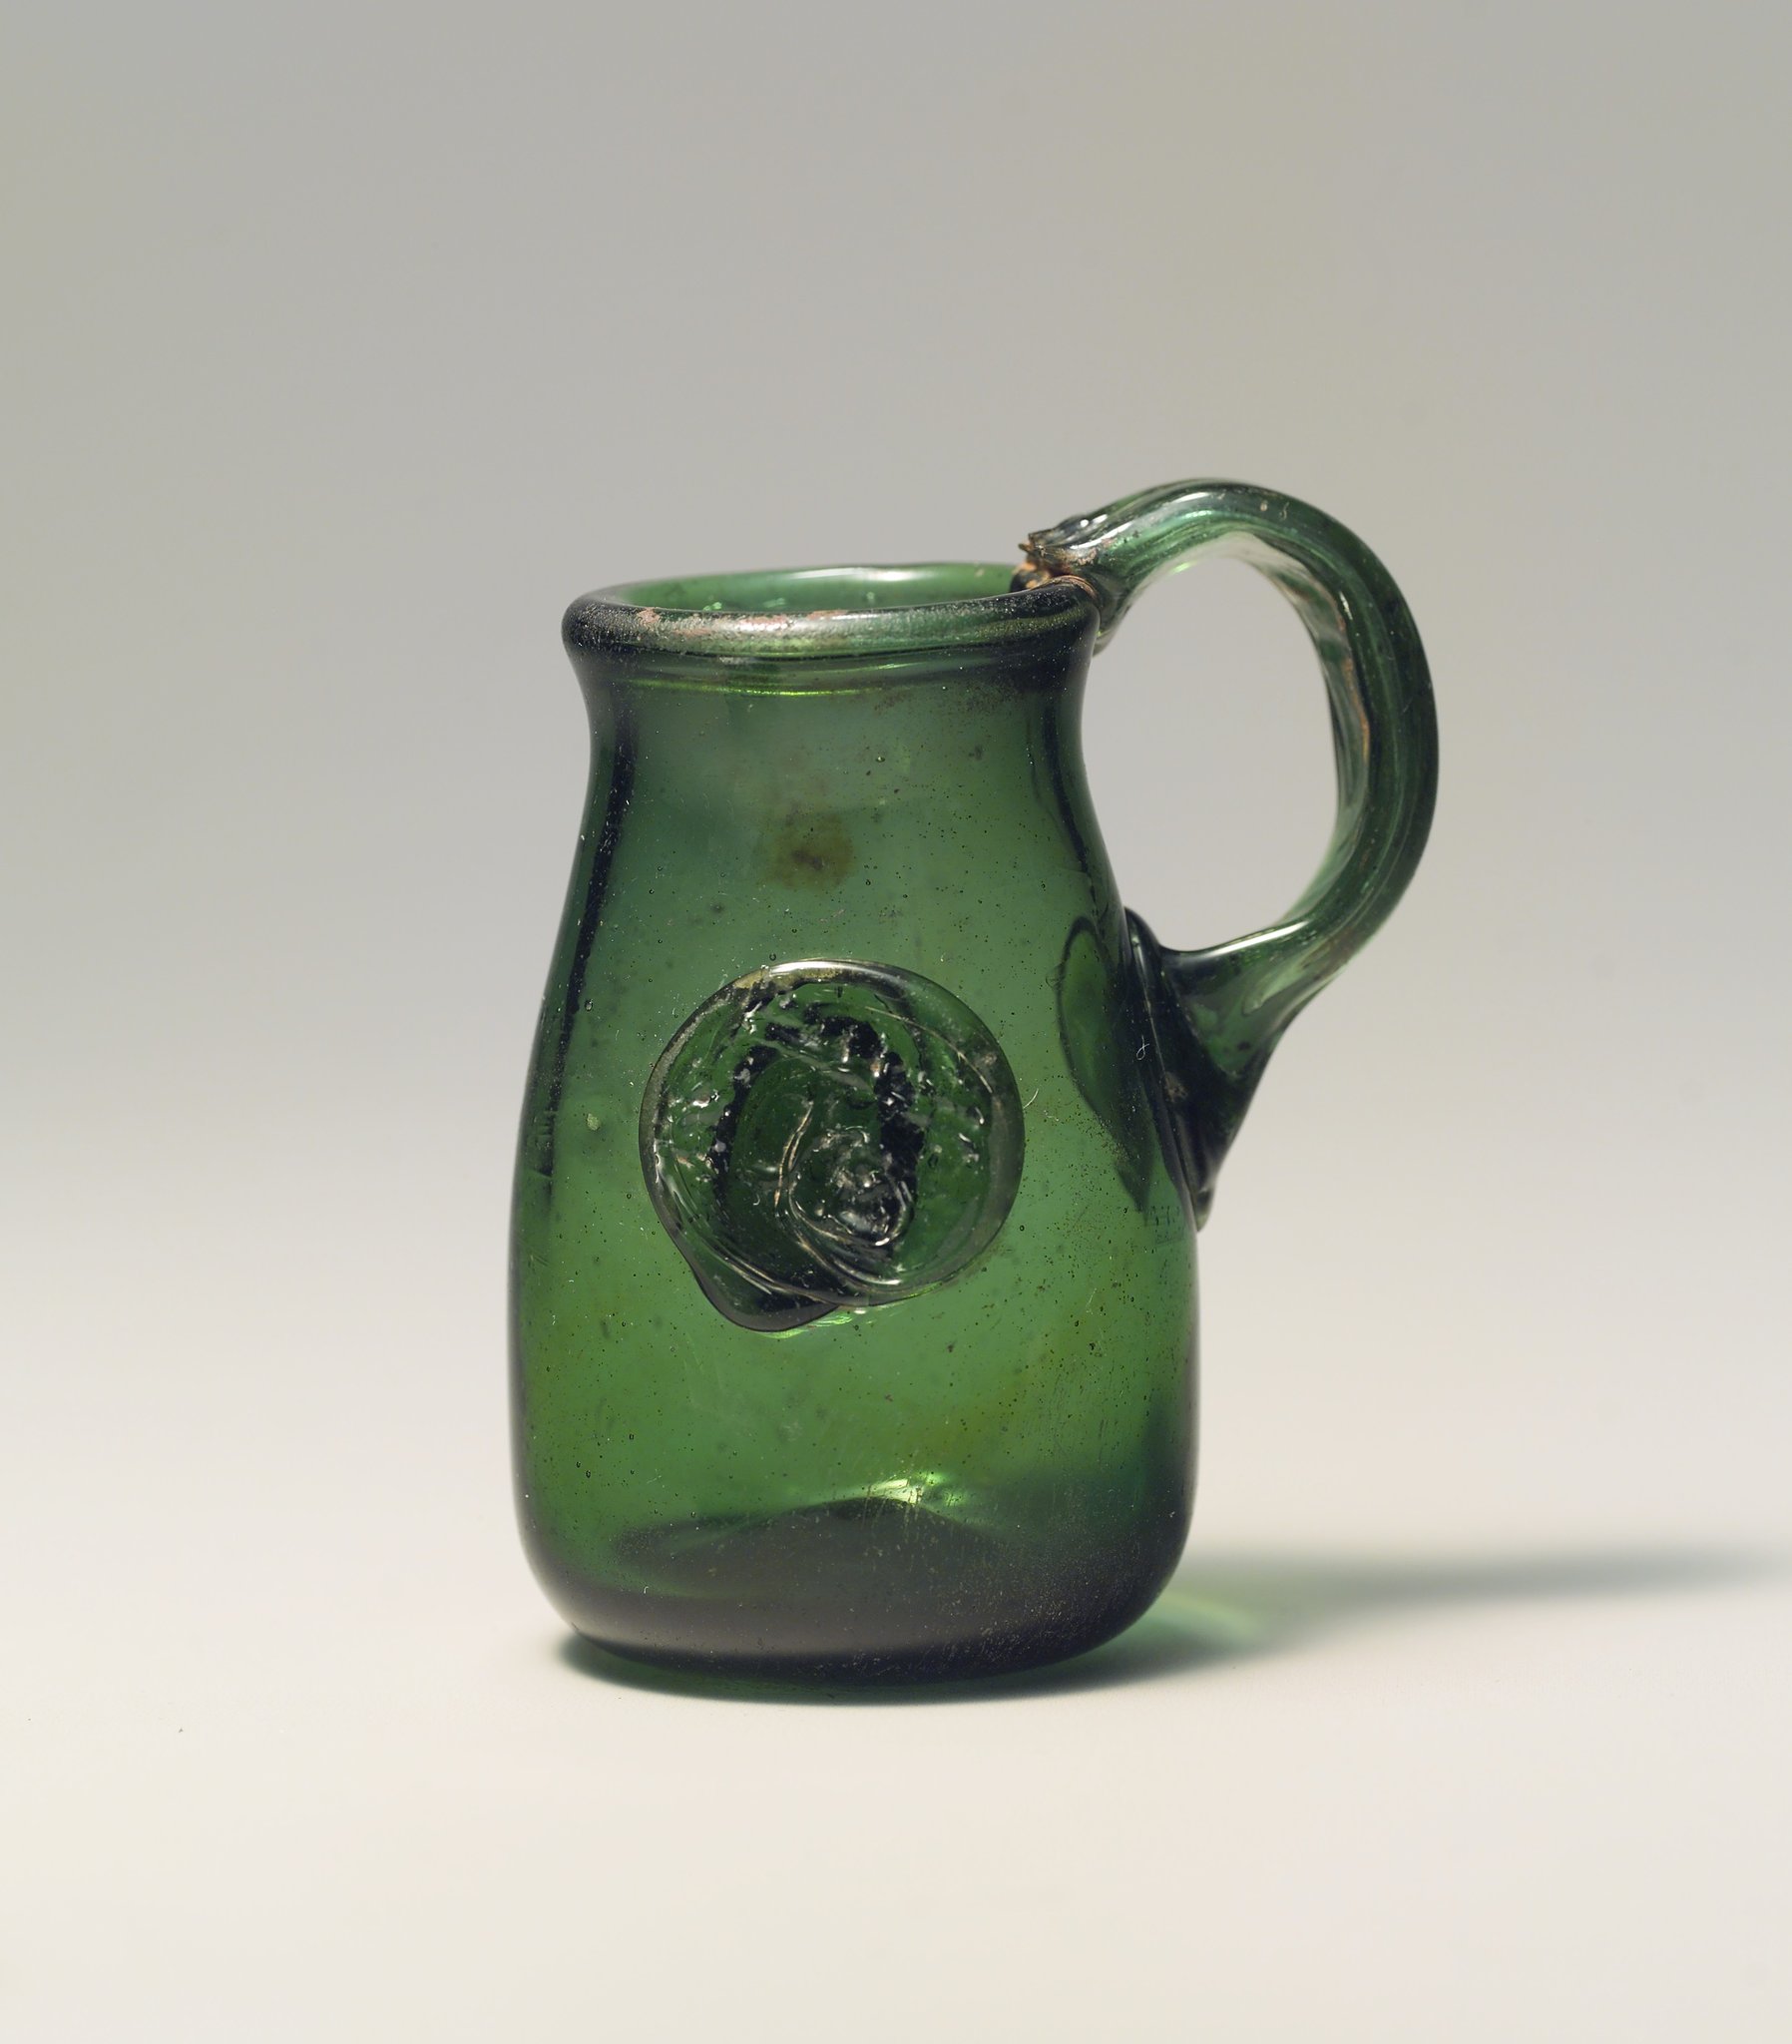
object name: measuring cup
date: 701-900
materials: glass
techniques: glassblowing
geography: egypt or syria